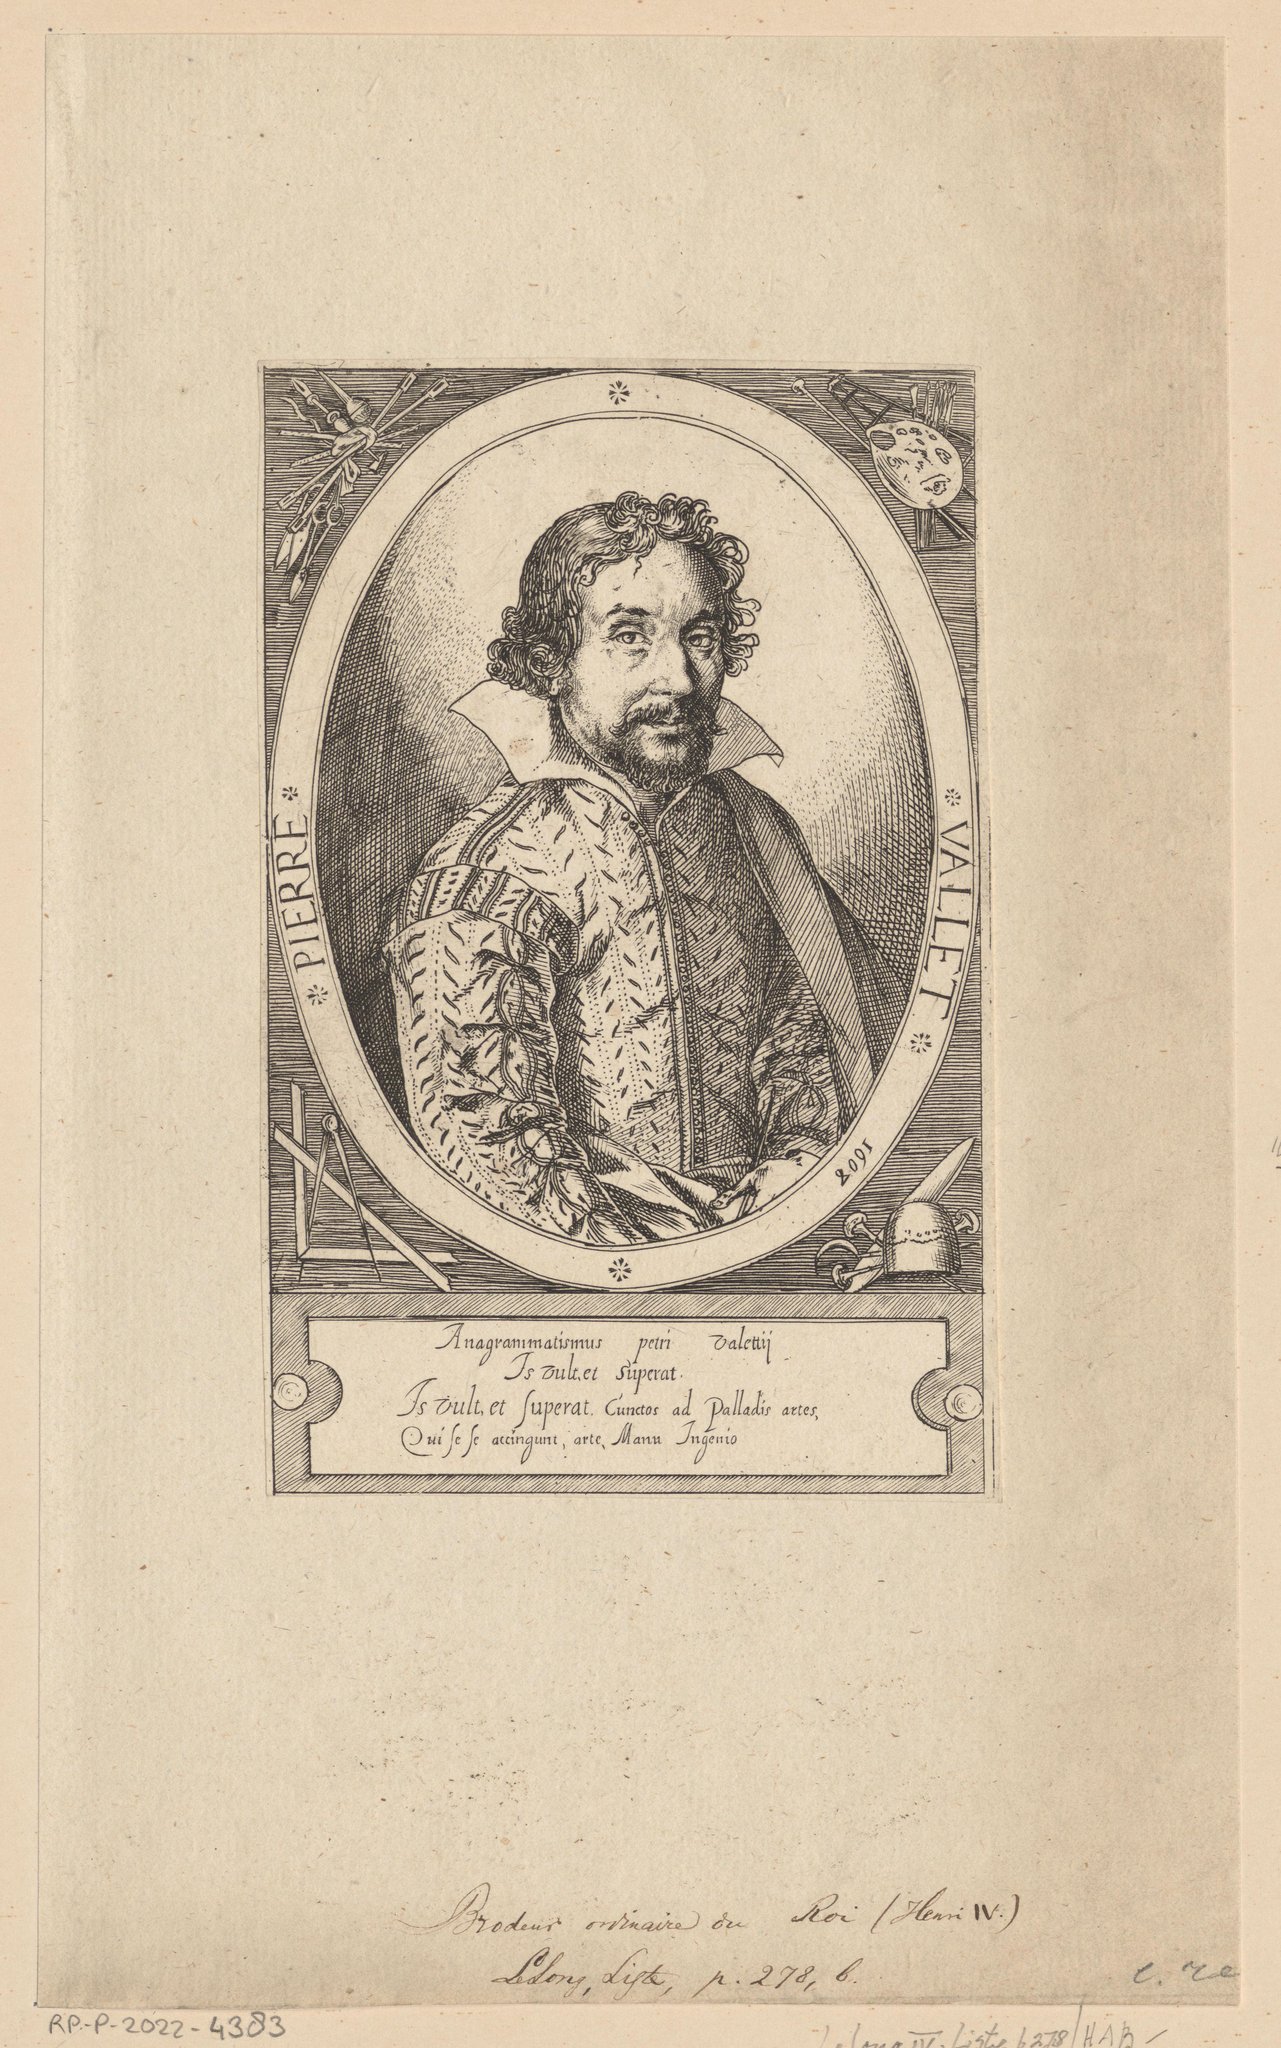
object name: book illustration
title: Zelfportret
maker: pierre vallet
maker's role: print maker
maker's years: 1575-1657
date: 1608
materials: paper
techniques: engraving, etching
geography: paris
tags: paris, print maker, pierre vallet, historical persons, portrait, self-portrait of graphic artist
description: Prent waarschijnlijk uit: Robin, Jean. Le Jardin du Roy tres Chrestien Henry IV Roy de France et de Navarre. Parijs: Vallet, Pierre, 1608.